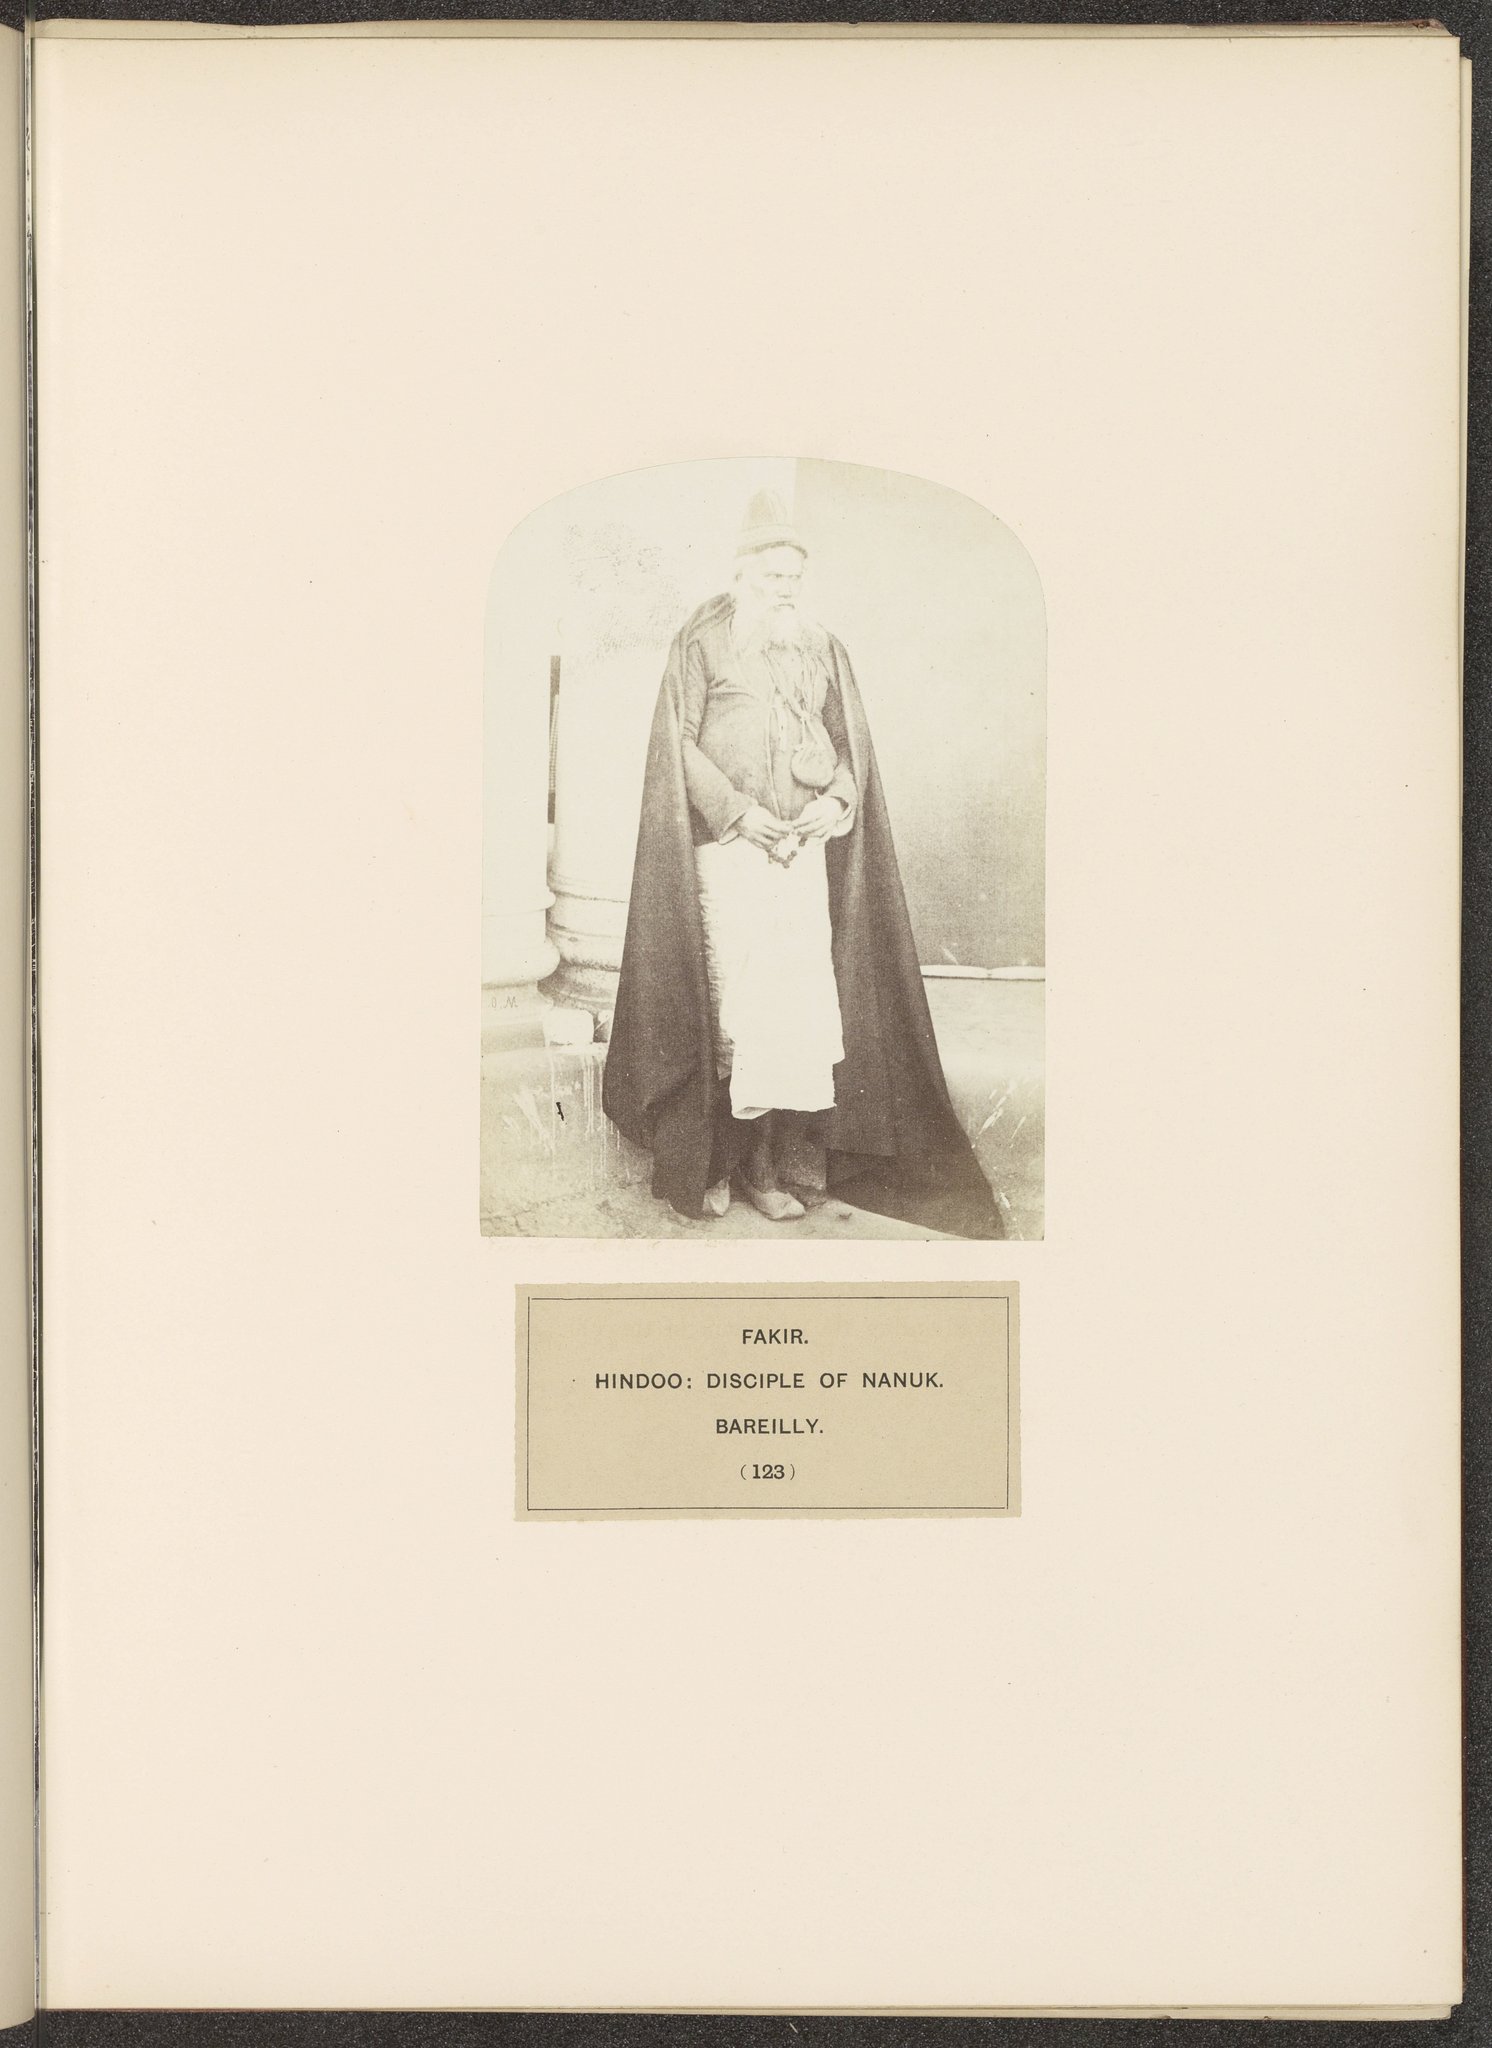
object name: photograph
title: Portrait of a fakir (ascetic) from the Nanakshahi community of Bareilly, Uttar Pradesh, India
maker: Anonymous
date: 1858-1868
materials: photographic support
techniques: albumen print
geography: bareilly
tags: asceticism ~ hinduism, buddhism, jainism, human races; peoples; nationalities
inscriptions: number: ‘(123)’, inscription: ‘FAKIR./ HINDOO: DISCIPLE OF NANUK./ BAREILLY.’